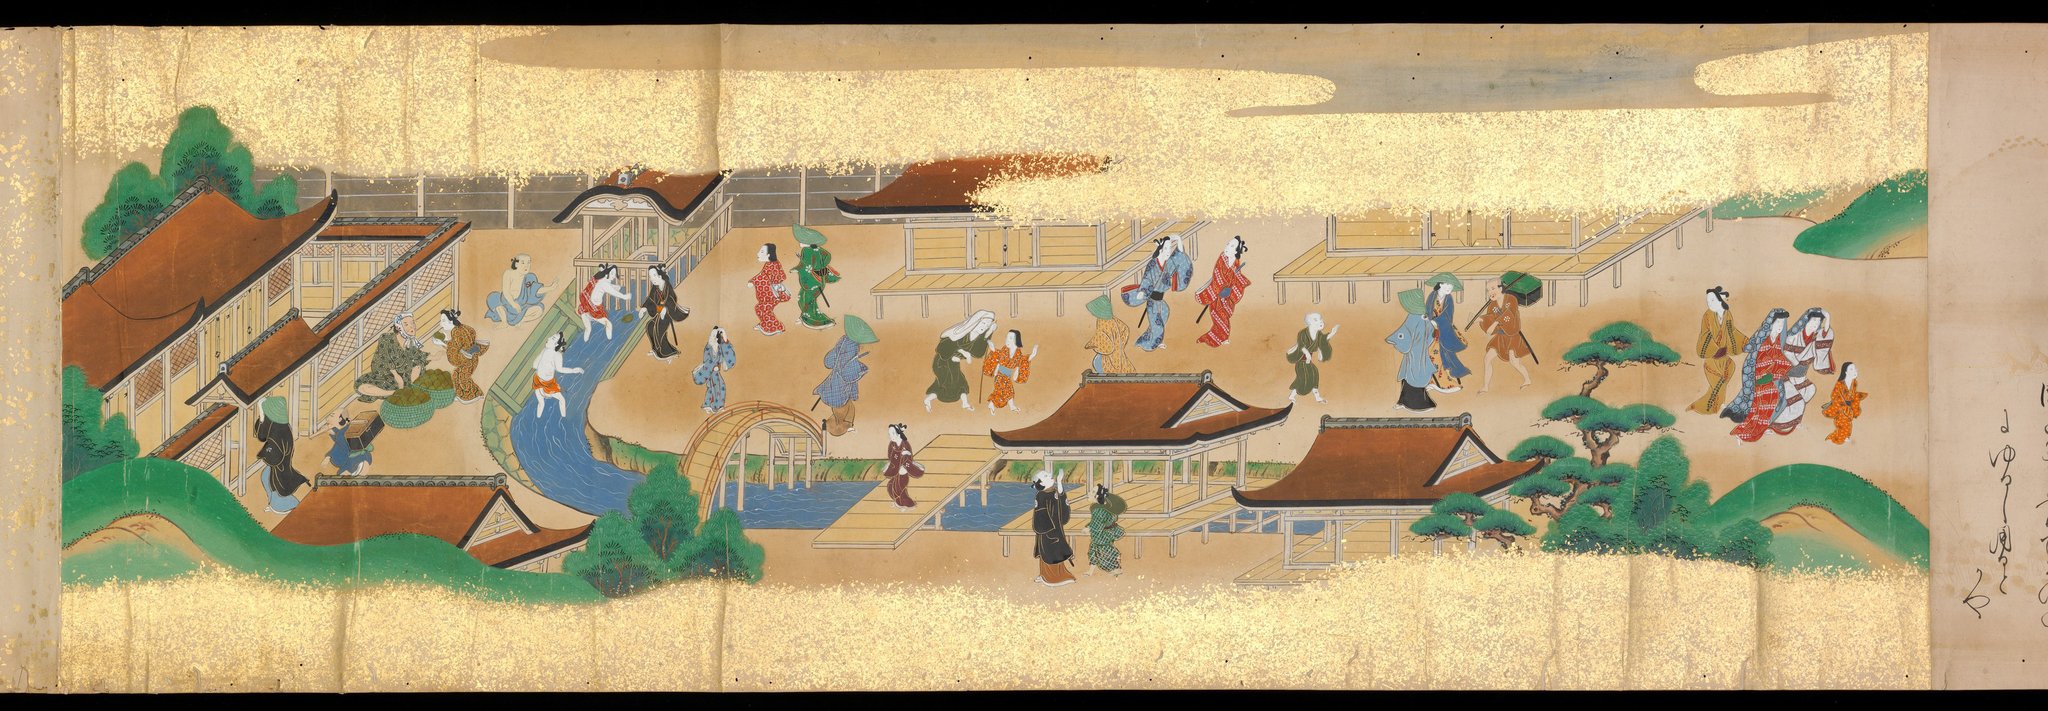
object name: handscroll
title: Festivities of the Twelve Months: “Sannō Hiyoshi Festivals Held on the Day of the Monkey in the Mid-Fourth Month”; Festivities of the Twelve Months: “Sumō Wrestling at Matsuno’o Shrine during the Hassaku Festival on the First Day of the Eighth Month”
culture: japanese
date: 1701-1733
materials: gold, ink, paper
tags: buildings,men,women